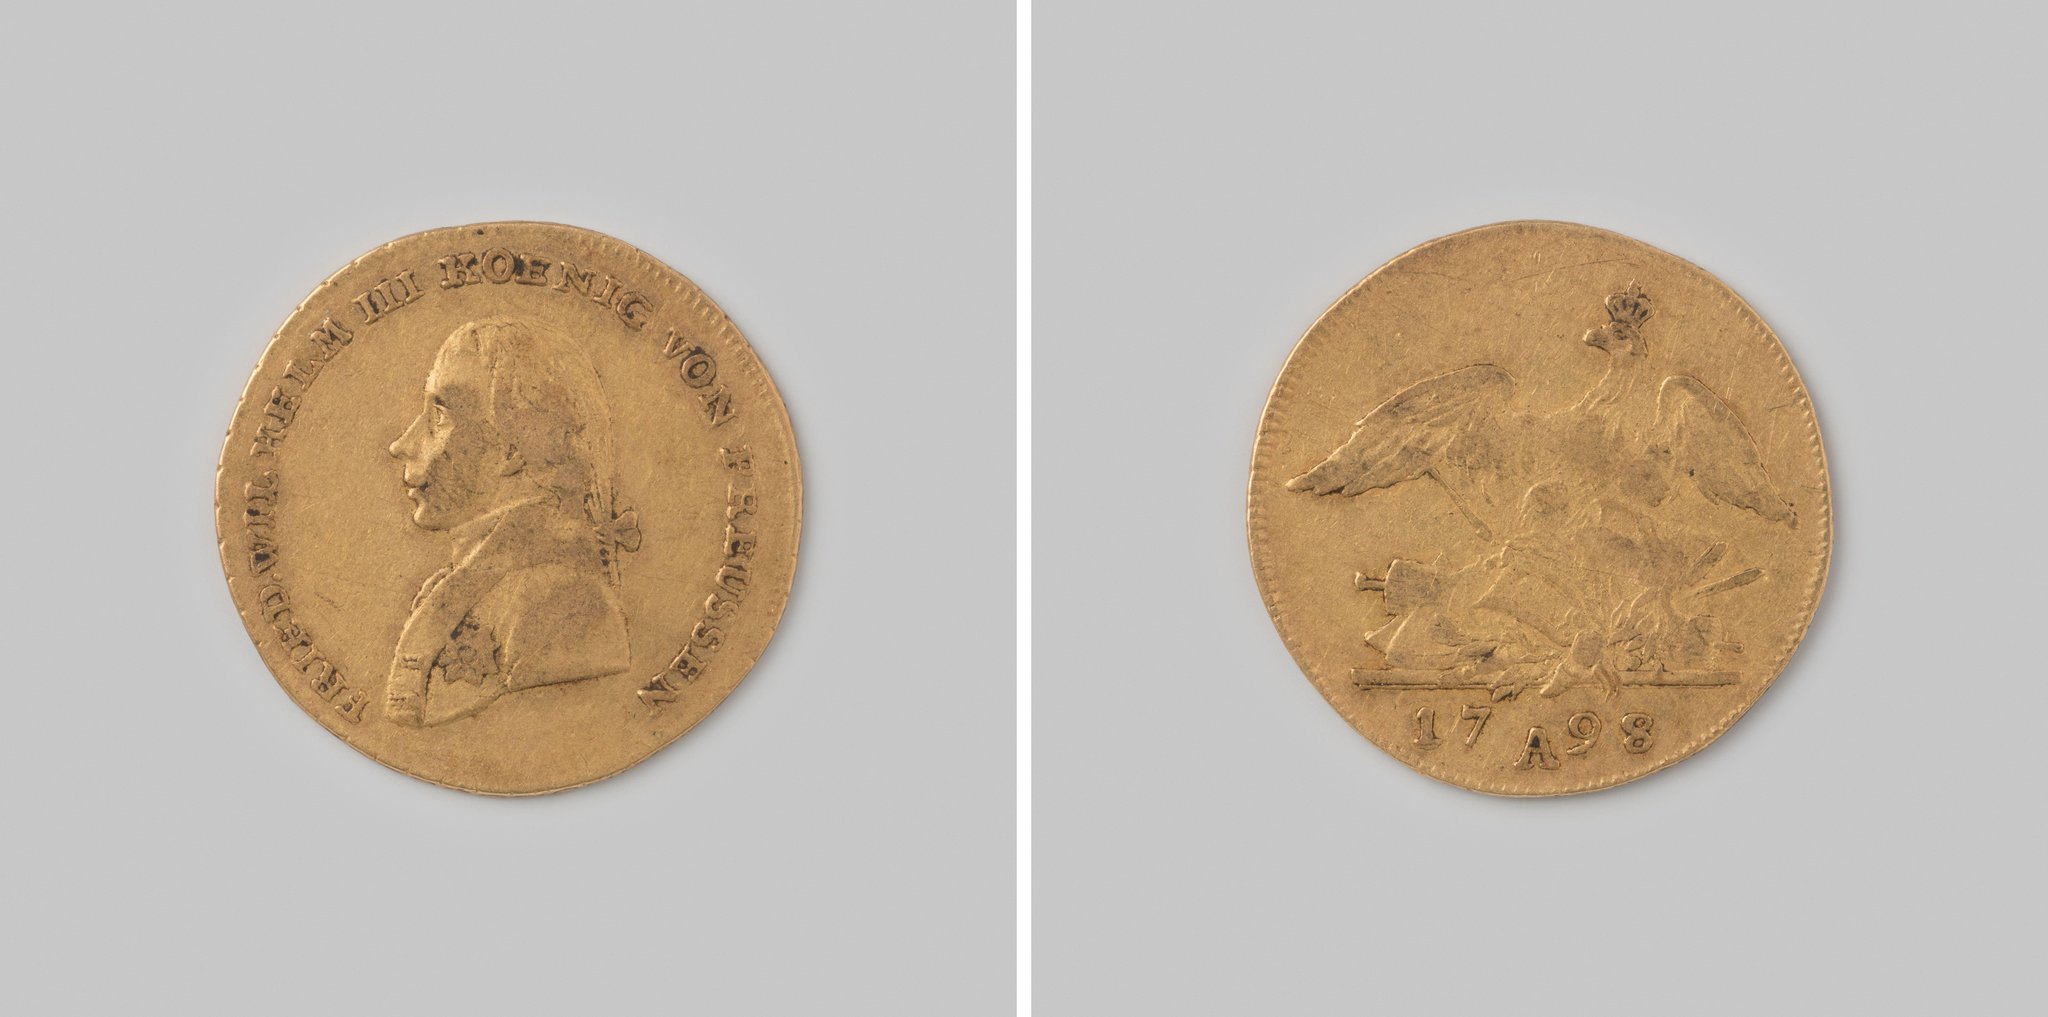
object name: coin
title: Pruisen, Friedrich Wilhelm III, friedrich d'or, 1798 A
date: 1798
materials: gold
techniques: striking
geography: berlin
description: Gouden munt. Voorzijde: borstbeeld van de koning naar links. Keerzijde: uit oorlogstrofeeën oprijzende gekroonde adelaar. In afsnede jaartal, waaronder letter A. Kartelrand.